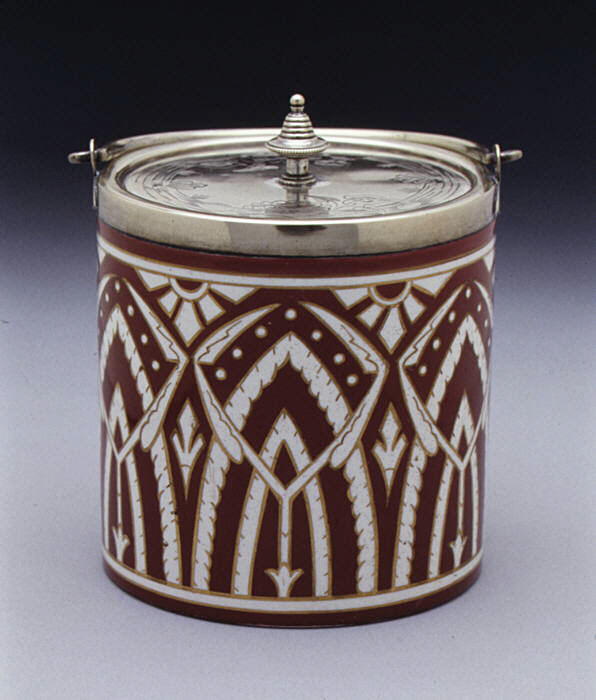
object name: box with cover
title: Biscuit box with cover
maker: christopher dresser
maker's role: designer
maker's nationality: british, scottish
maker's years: 1834-1904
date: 1870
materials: earthenware, silver